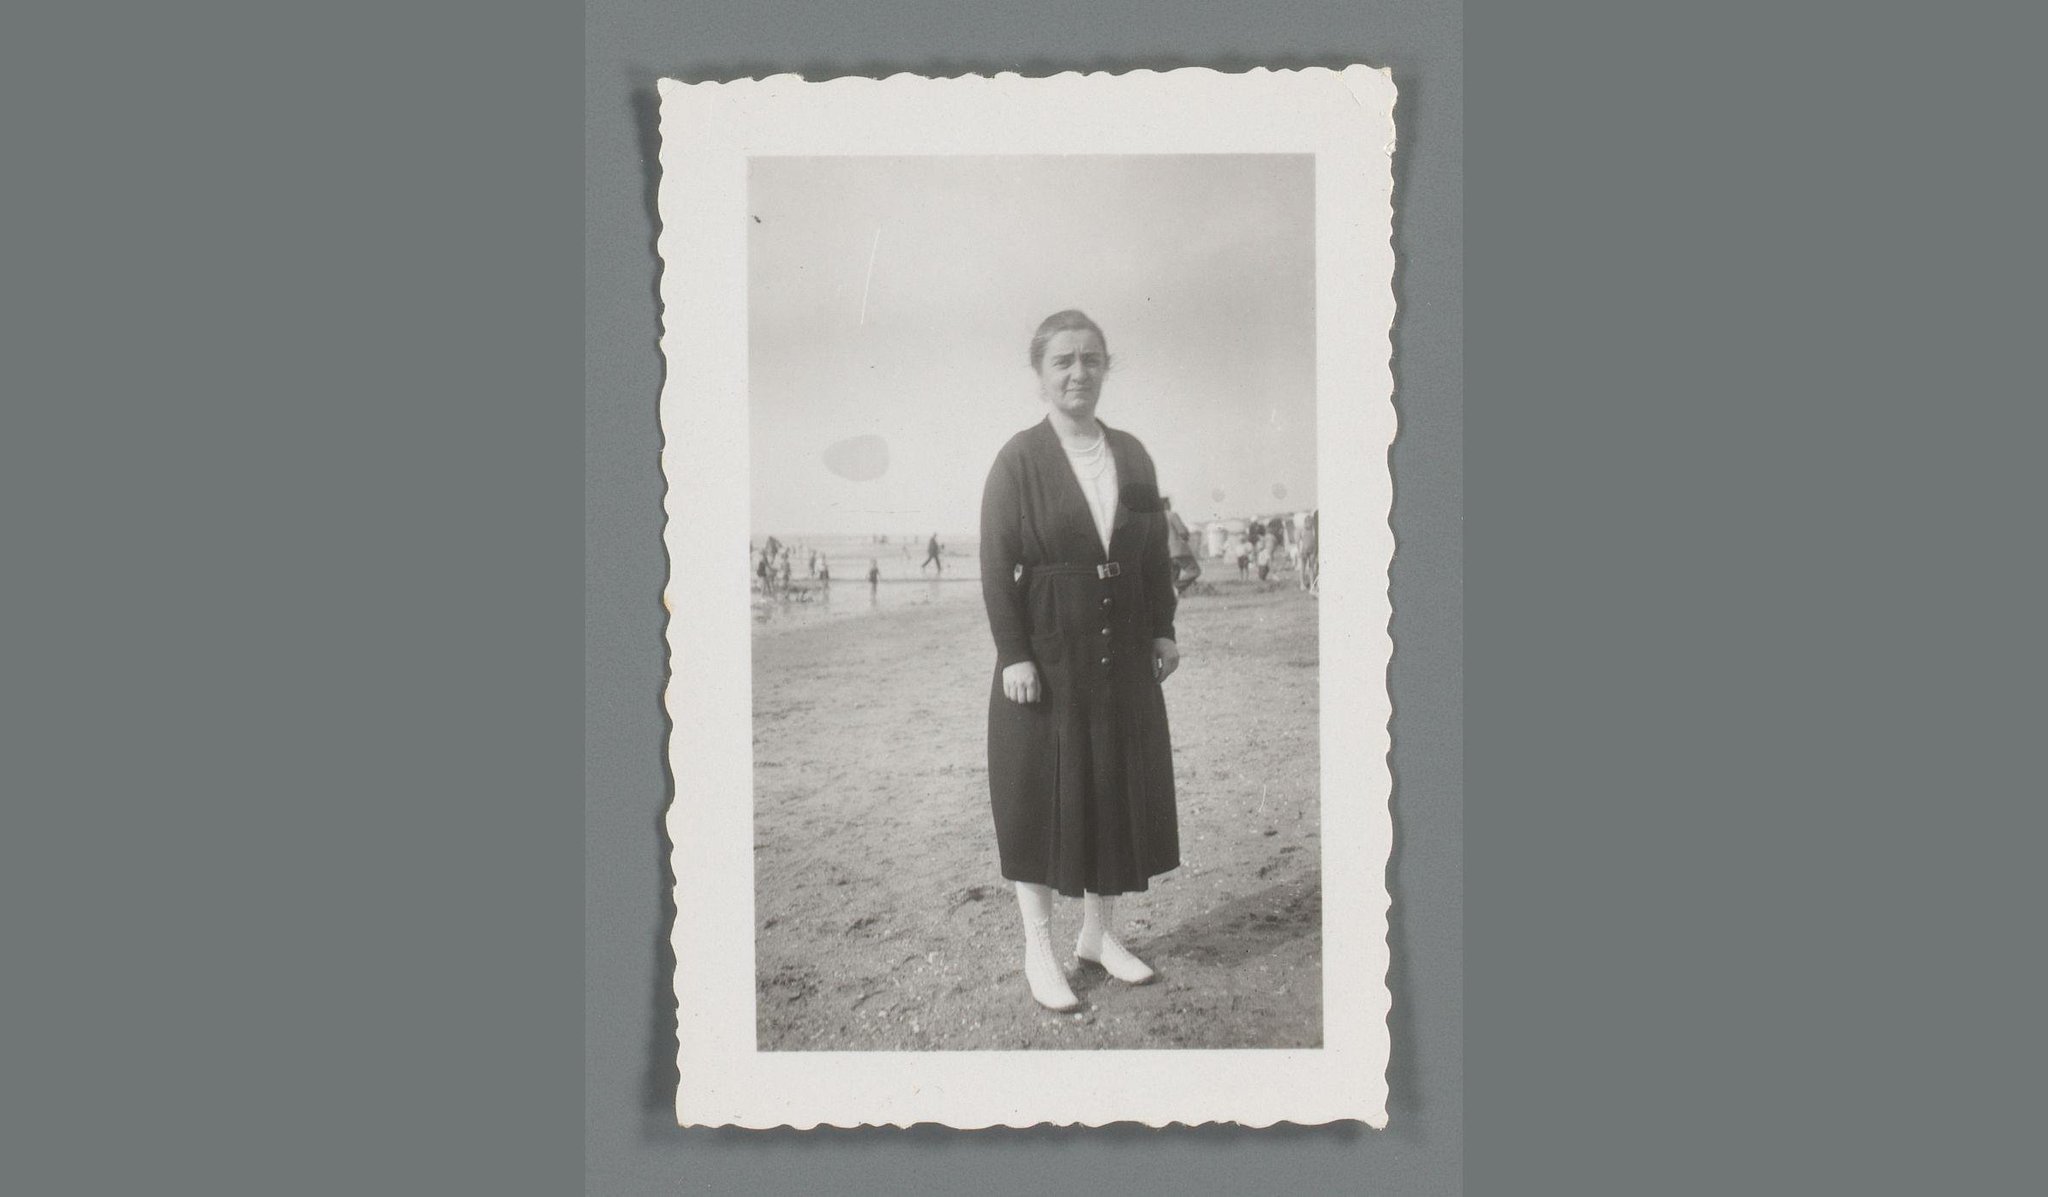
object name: photograph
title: Portret van een onbekende vrouw op het strand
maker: Anonymous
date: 1908-1933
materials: paper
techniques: gelatin silver print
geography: wijk aan zee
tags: beach (as place of recreation), historical persons not known by name - bb - woman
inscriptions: inscription: ‘Wijk aan Zee/ 5/ Aug '33/ Jh[?]/ 030’